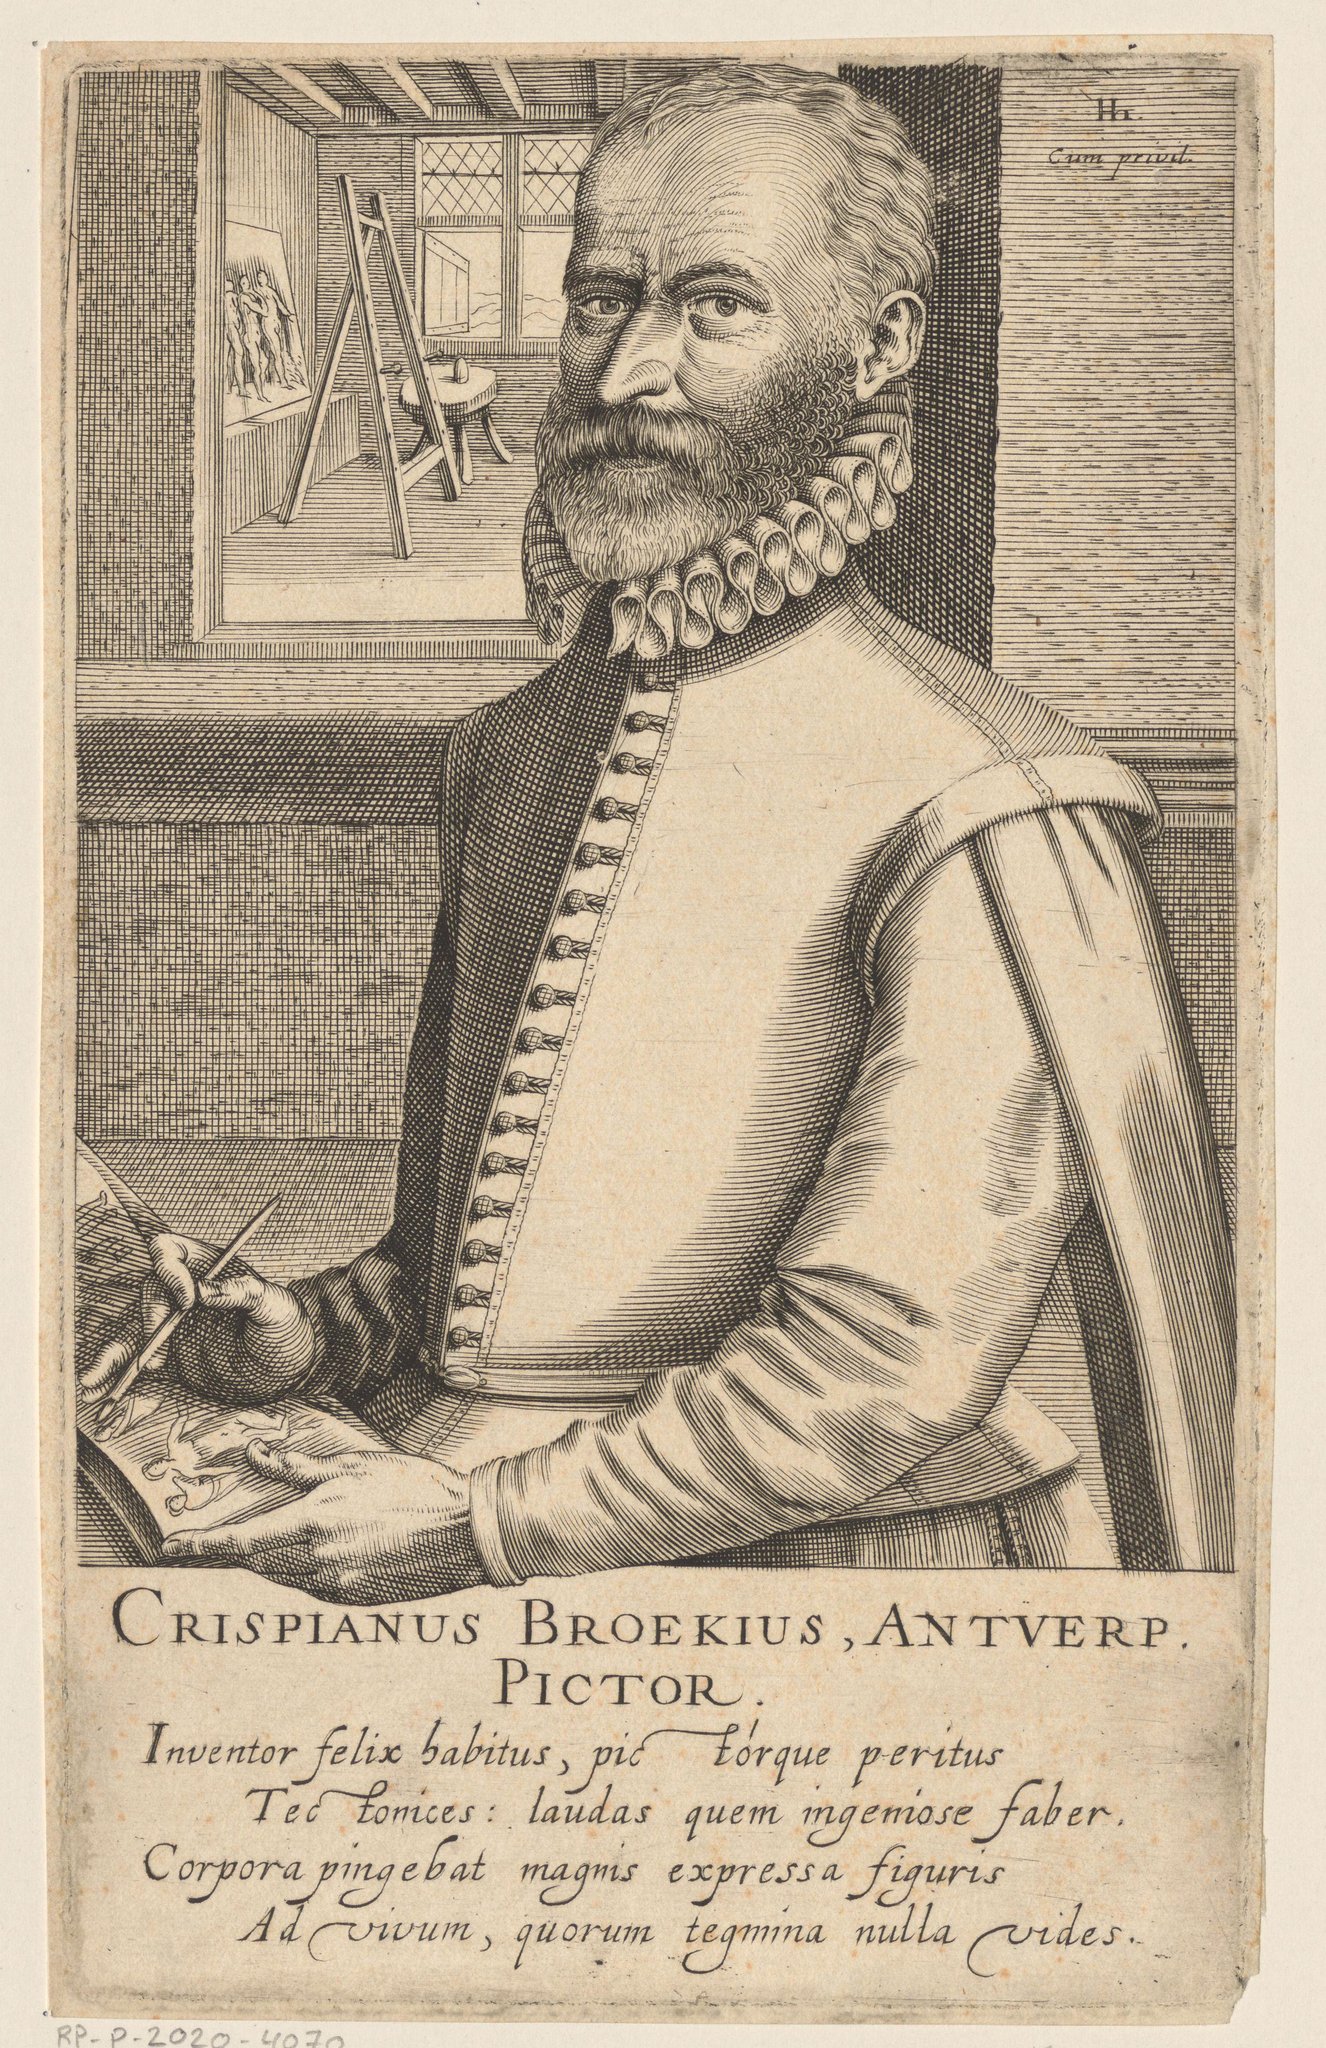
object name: print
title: Pictorum aliquot celebrium praecipuae Germaniae Inferioris effigies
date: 1610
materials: paper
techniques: engraving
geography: the hague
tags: mechelen, antwerp, painter, print maker, draughtsman, chrispijn van den broeck, historical persons, workshop, studio ~ painter, portrait, self-portrait of painter